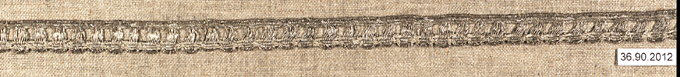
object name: piece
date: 1801-1900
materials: metal thread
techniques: lace